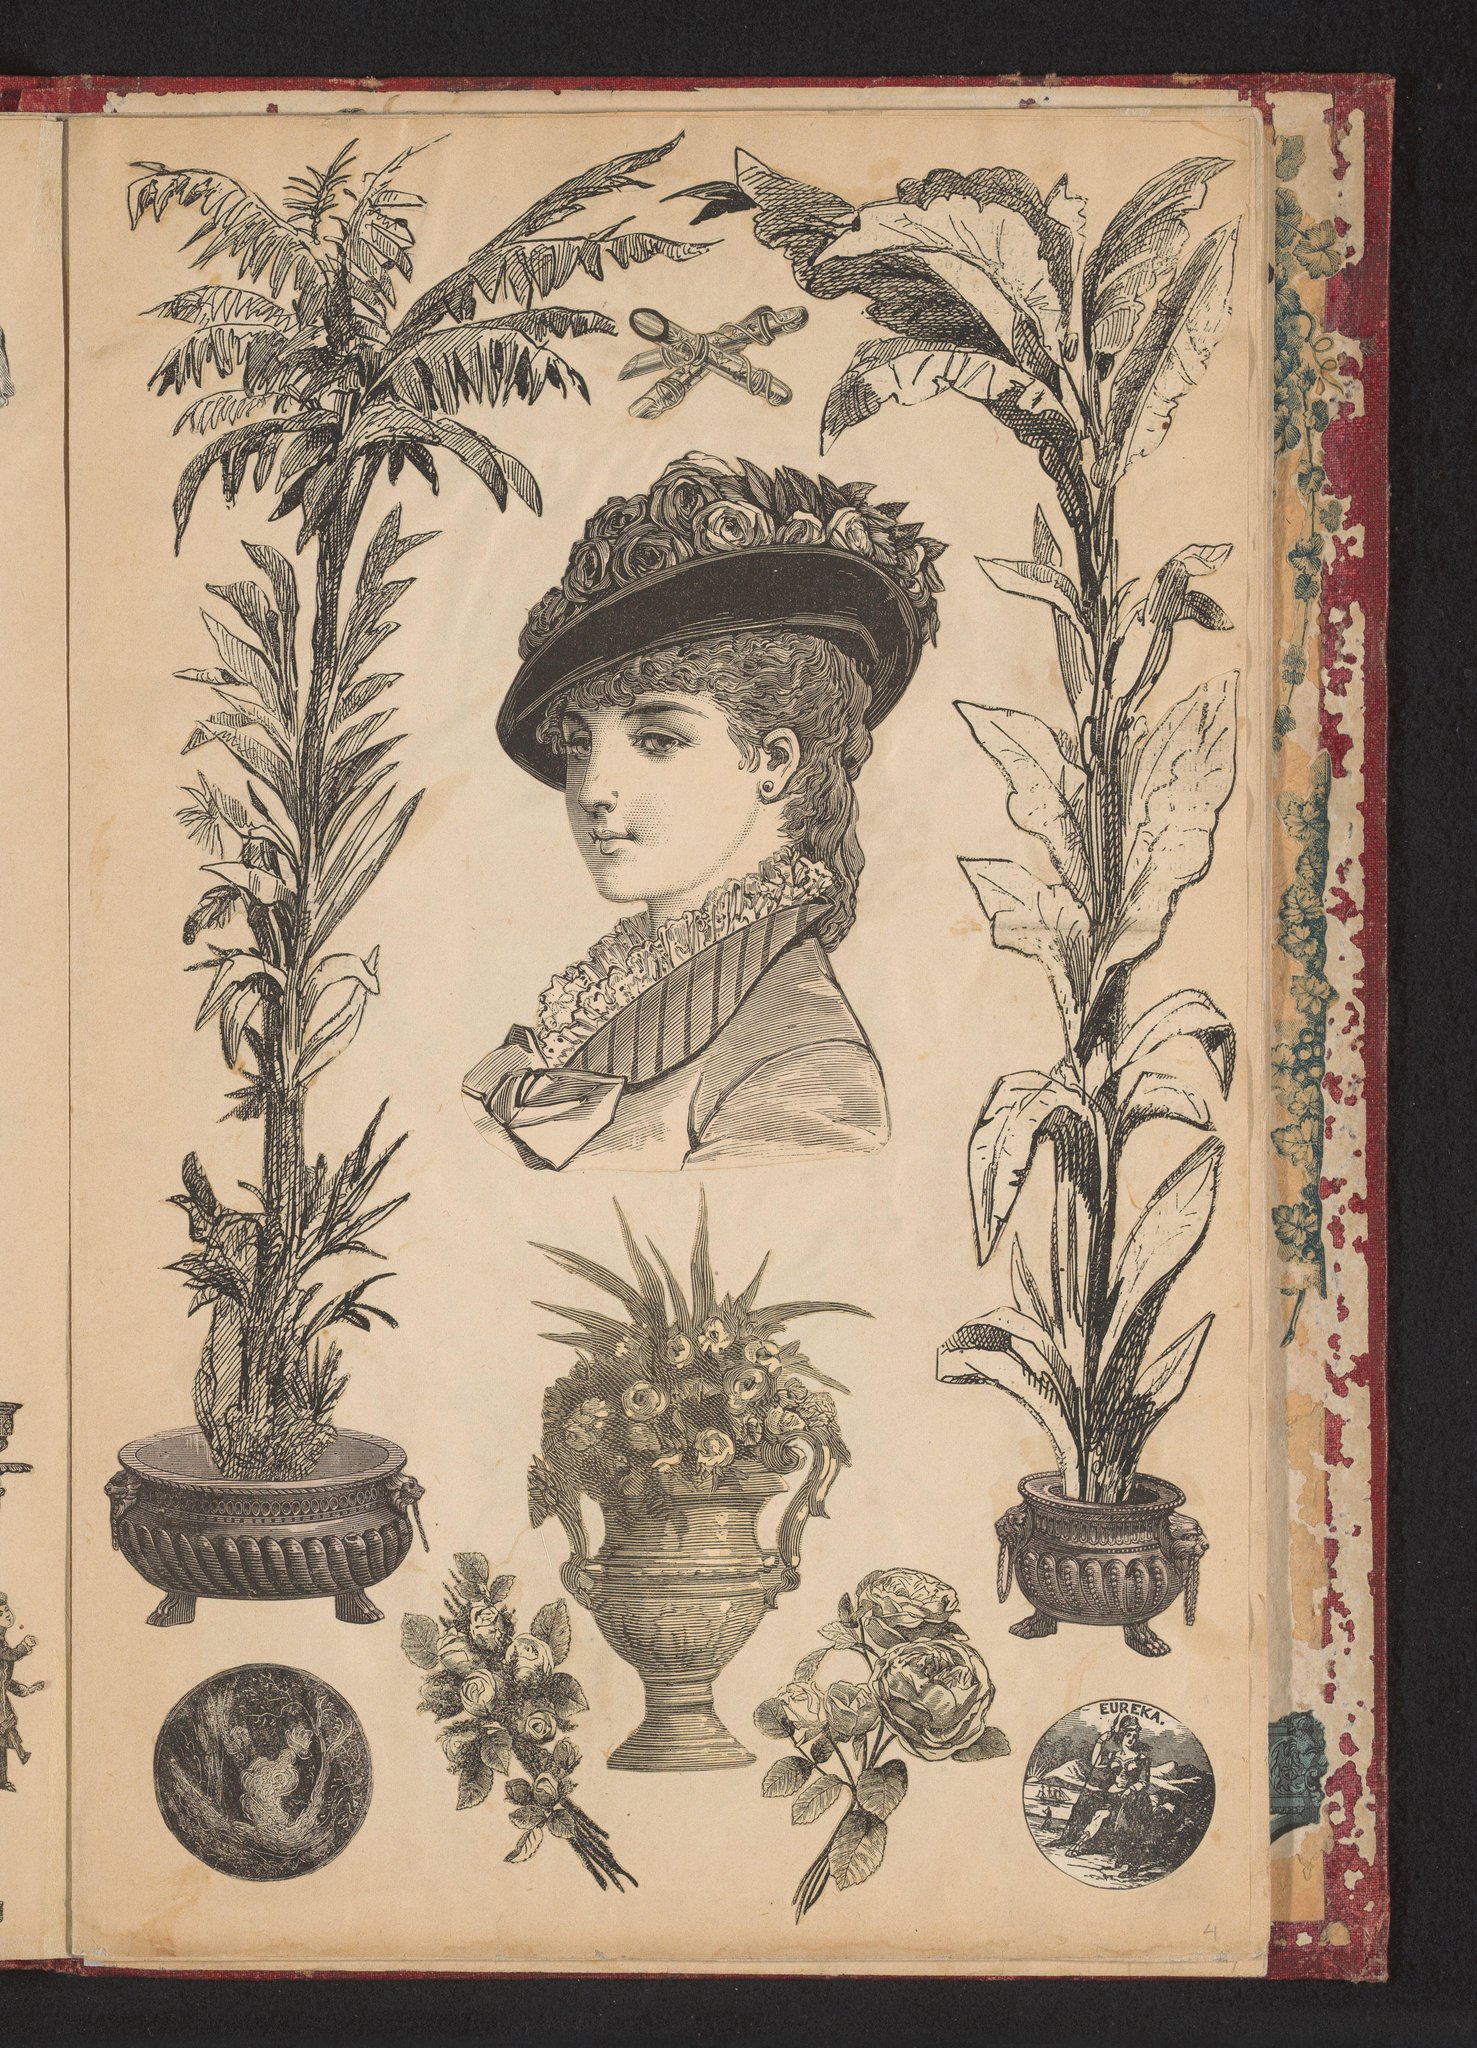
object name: collage visual work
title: Collage van uitgeknipte prenten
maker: Anonymous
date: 1870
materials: paper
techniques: engraving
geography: paris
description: Collage van uitgeknipte prenten. Onderdeel van een album met 18 bladen, aan beide zijden beplakt met uitgeknipte prenten, vermoedelijk afkomstig uit 19e-eeuwse tijdschiften.